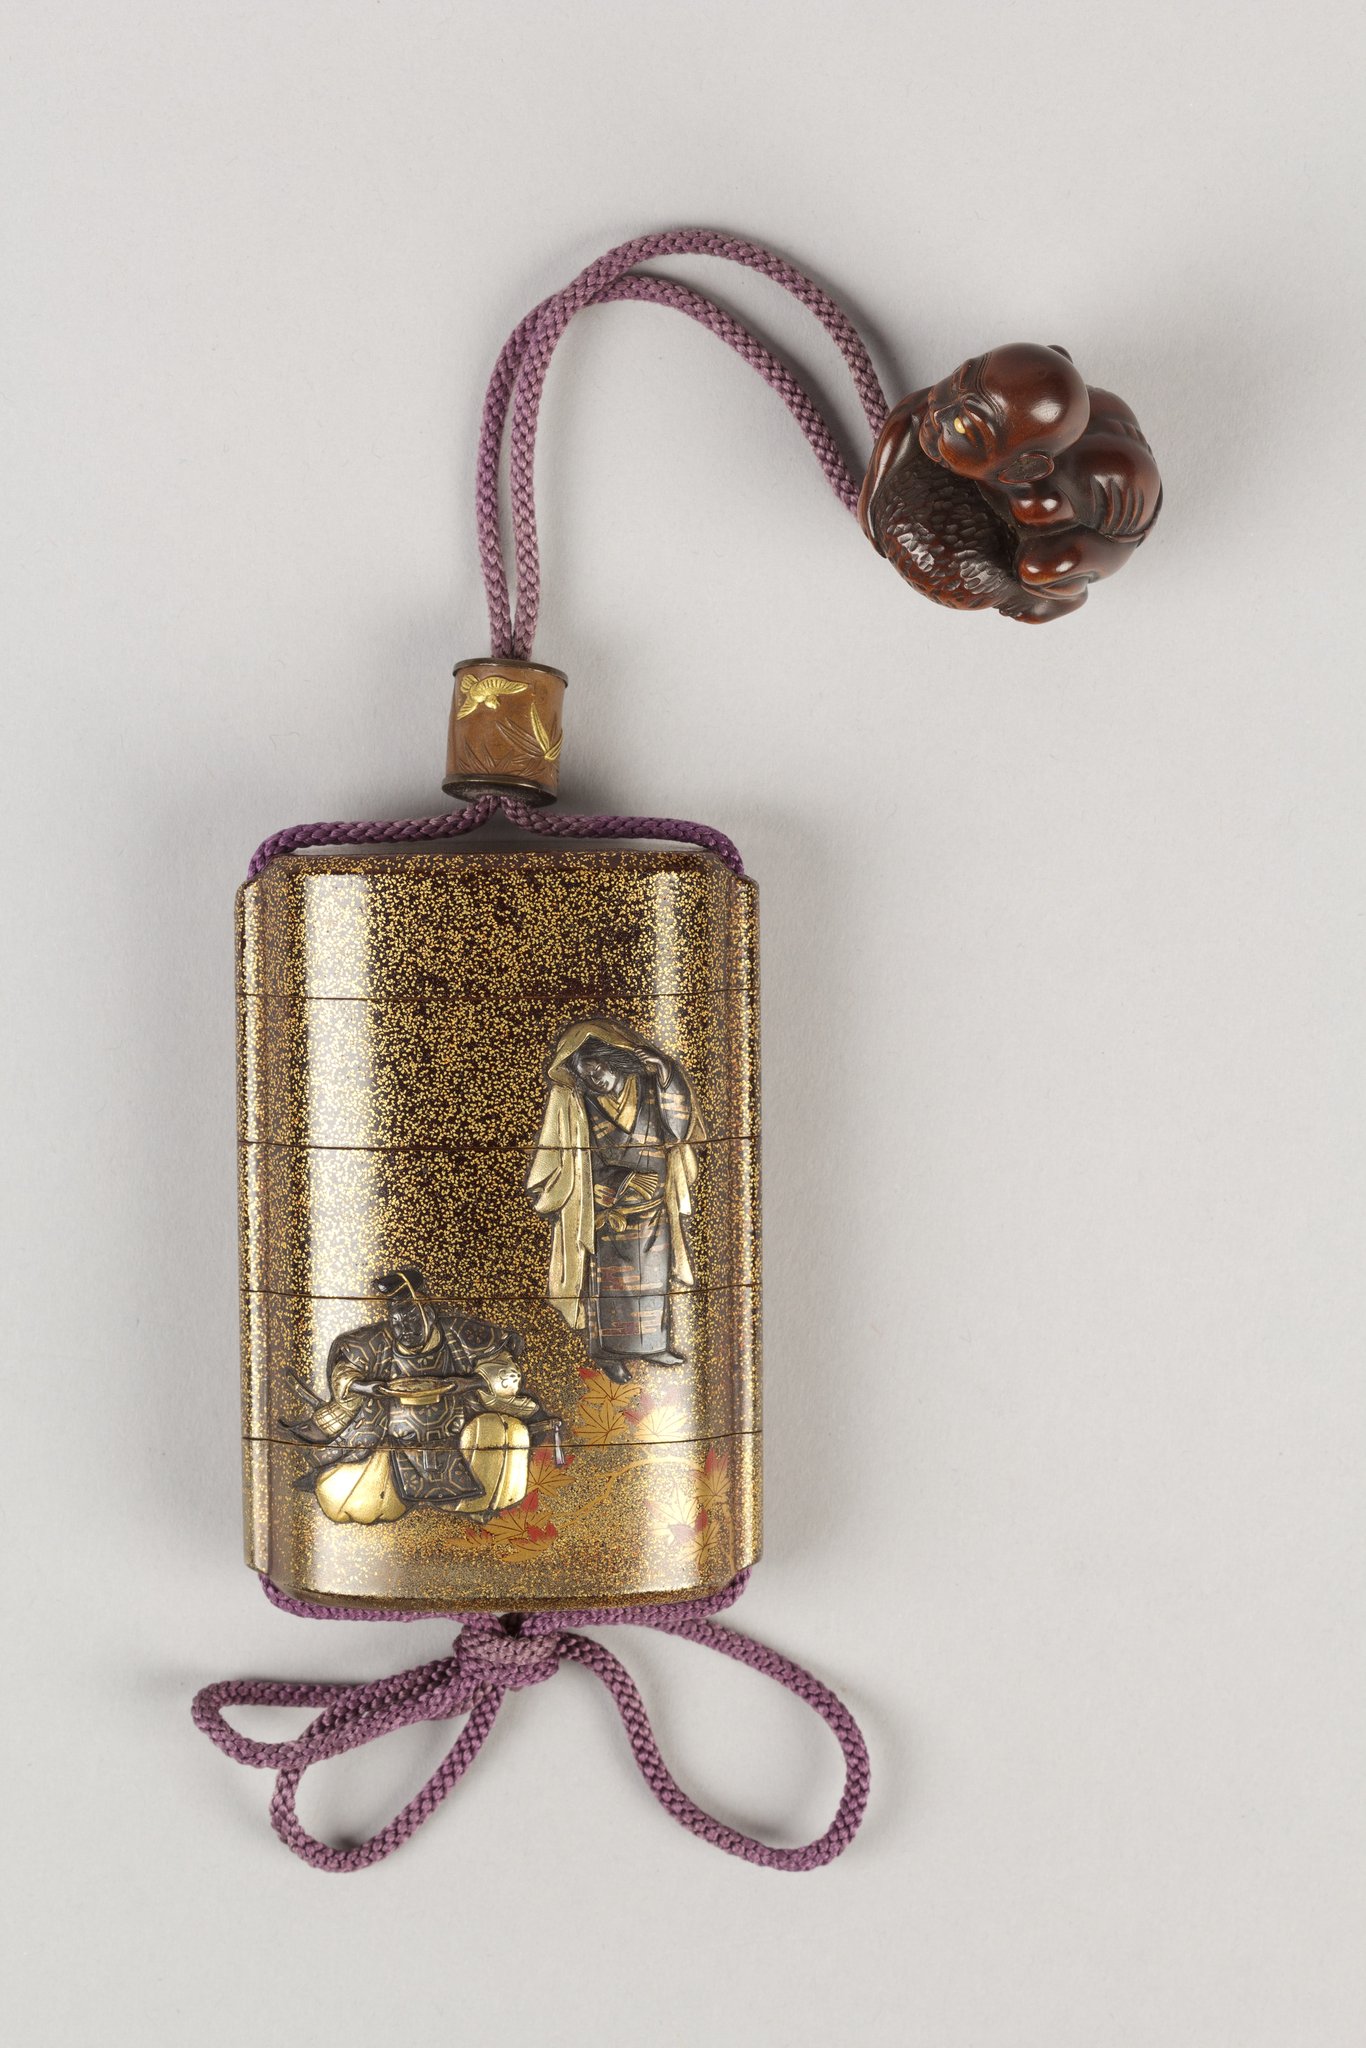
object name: inrō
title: Case (Inrō) with Design of Seated Courtier Drinking Sake and a Young Woman with Maple Leaves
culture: japanese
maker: kajikawa katsuhira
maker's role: artist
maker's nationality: japanese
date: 1767-1900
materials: gold, lacquer, metal, wood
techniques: carving, inlay, polish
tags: women,drinking